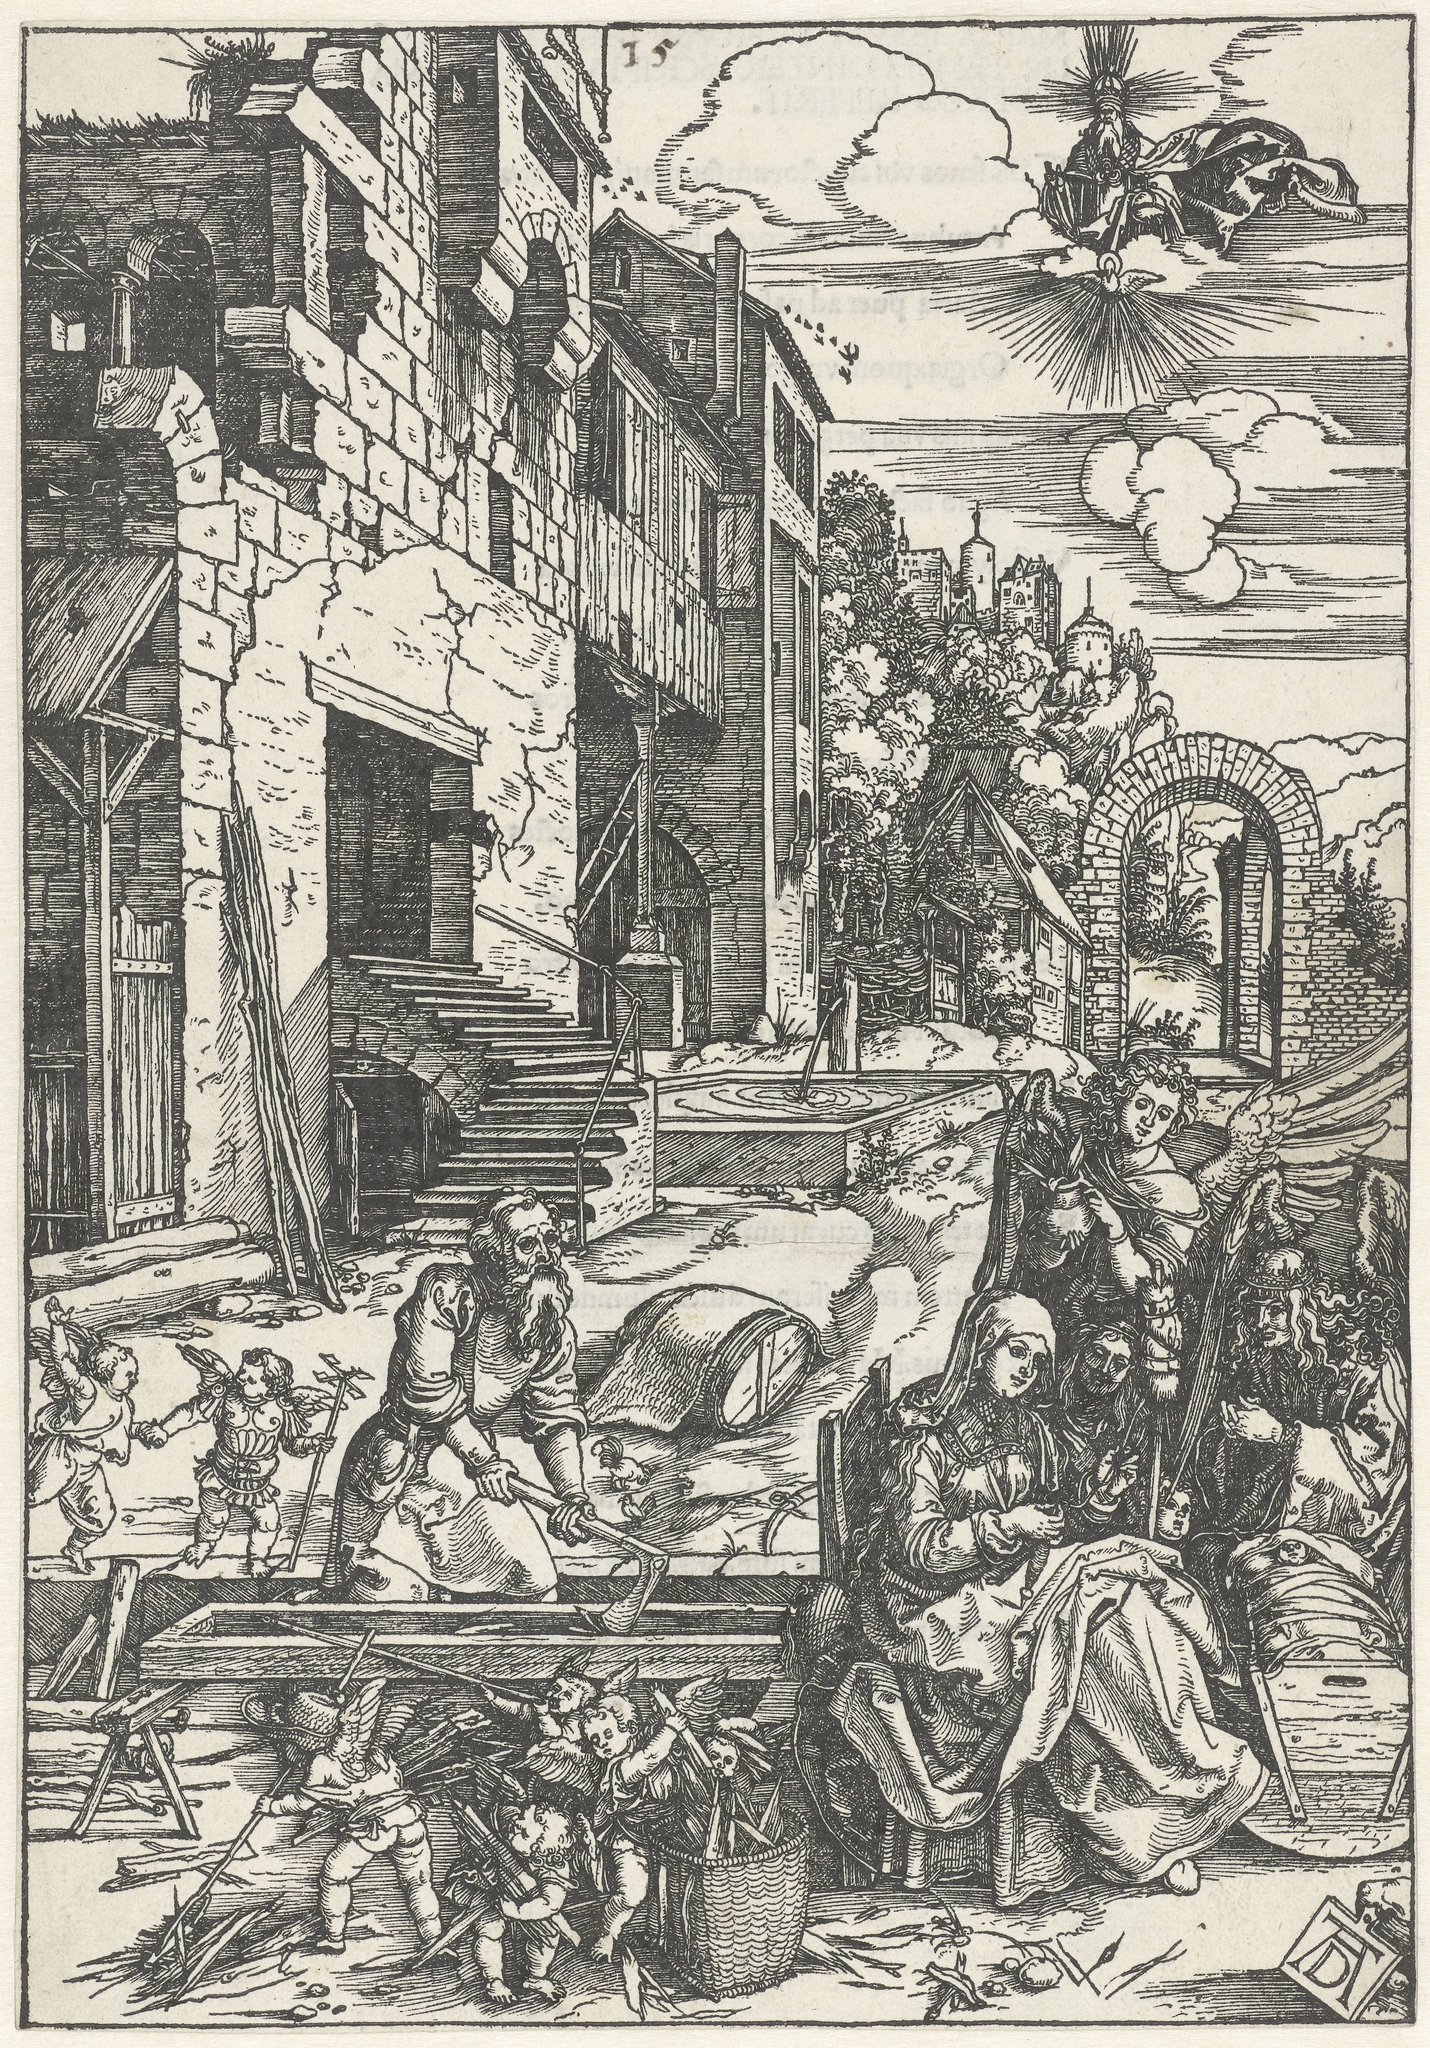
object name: print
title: Leven van Maria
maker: albrecht dürer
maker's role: draughtsman, painter, print maker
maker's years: 1471-1528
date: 1500-1504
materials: paper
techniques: letterpress printing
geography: nuremberg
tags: stay of the holy family in egypt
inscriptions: inscription: ‘15’, collector's mark: Lugt 2228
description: Voor een vervallen gebouw zit Maria naast enkele engelen te spinnen, terwijl ze met de voet het bedje waarin het Christuskind ligt laat wiegen. Achter haar werkt Jozef aan een trog, geholpen door putti. Op versozijde gedrukte Latijnse tekst. Deze prent is onderdeel van een serie van 20 prenten, bestaand uit een titelprent en 19 prenten met scènes uit het leven van Maria.